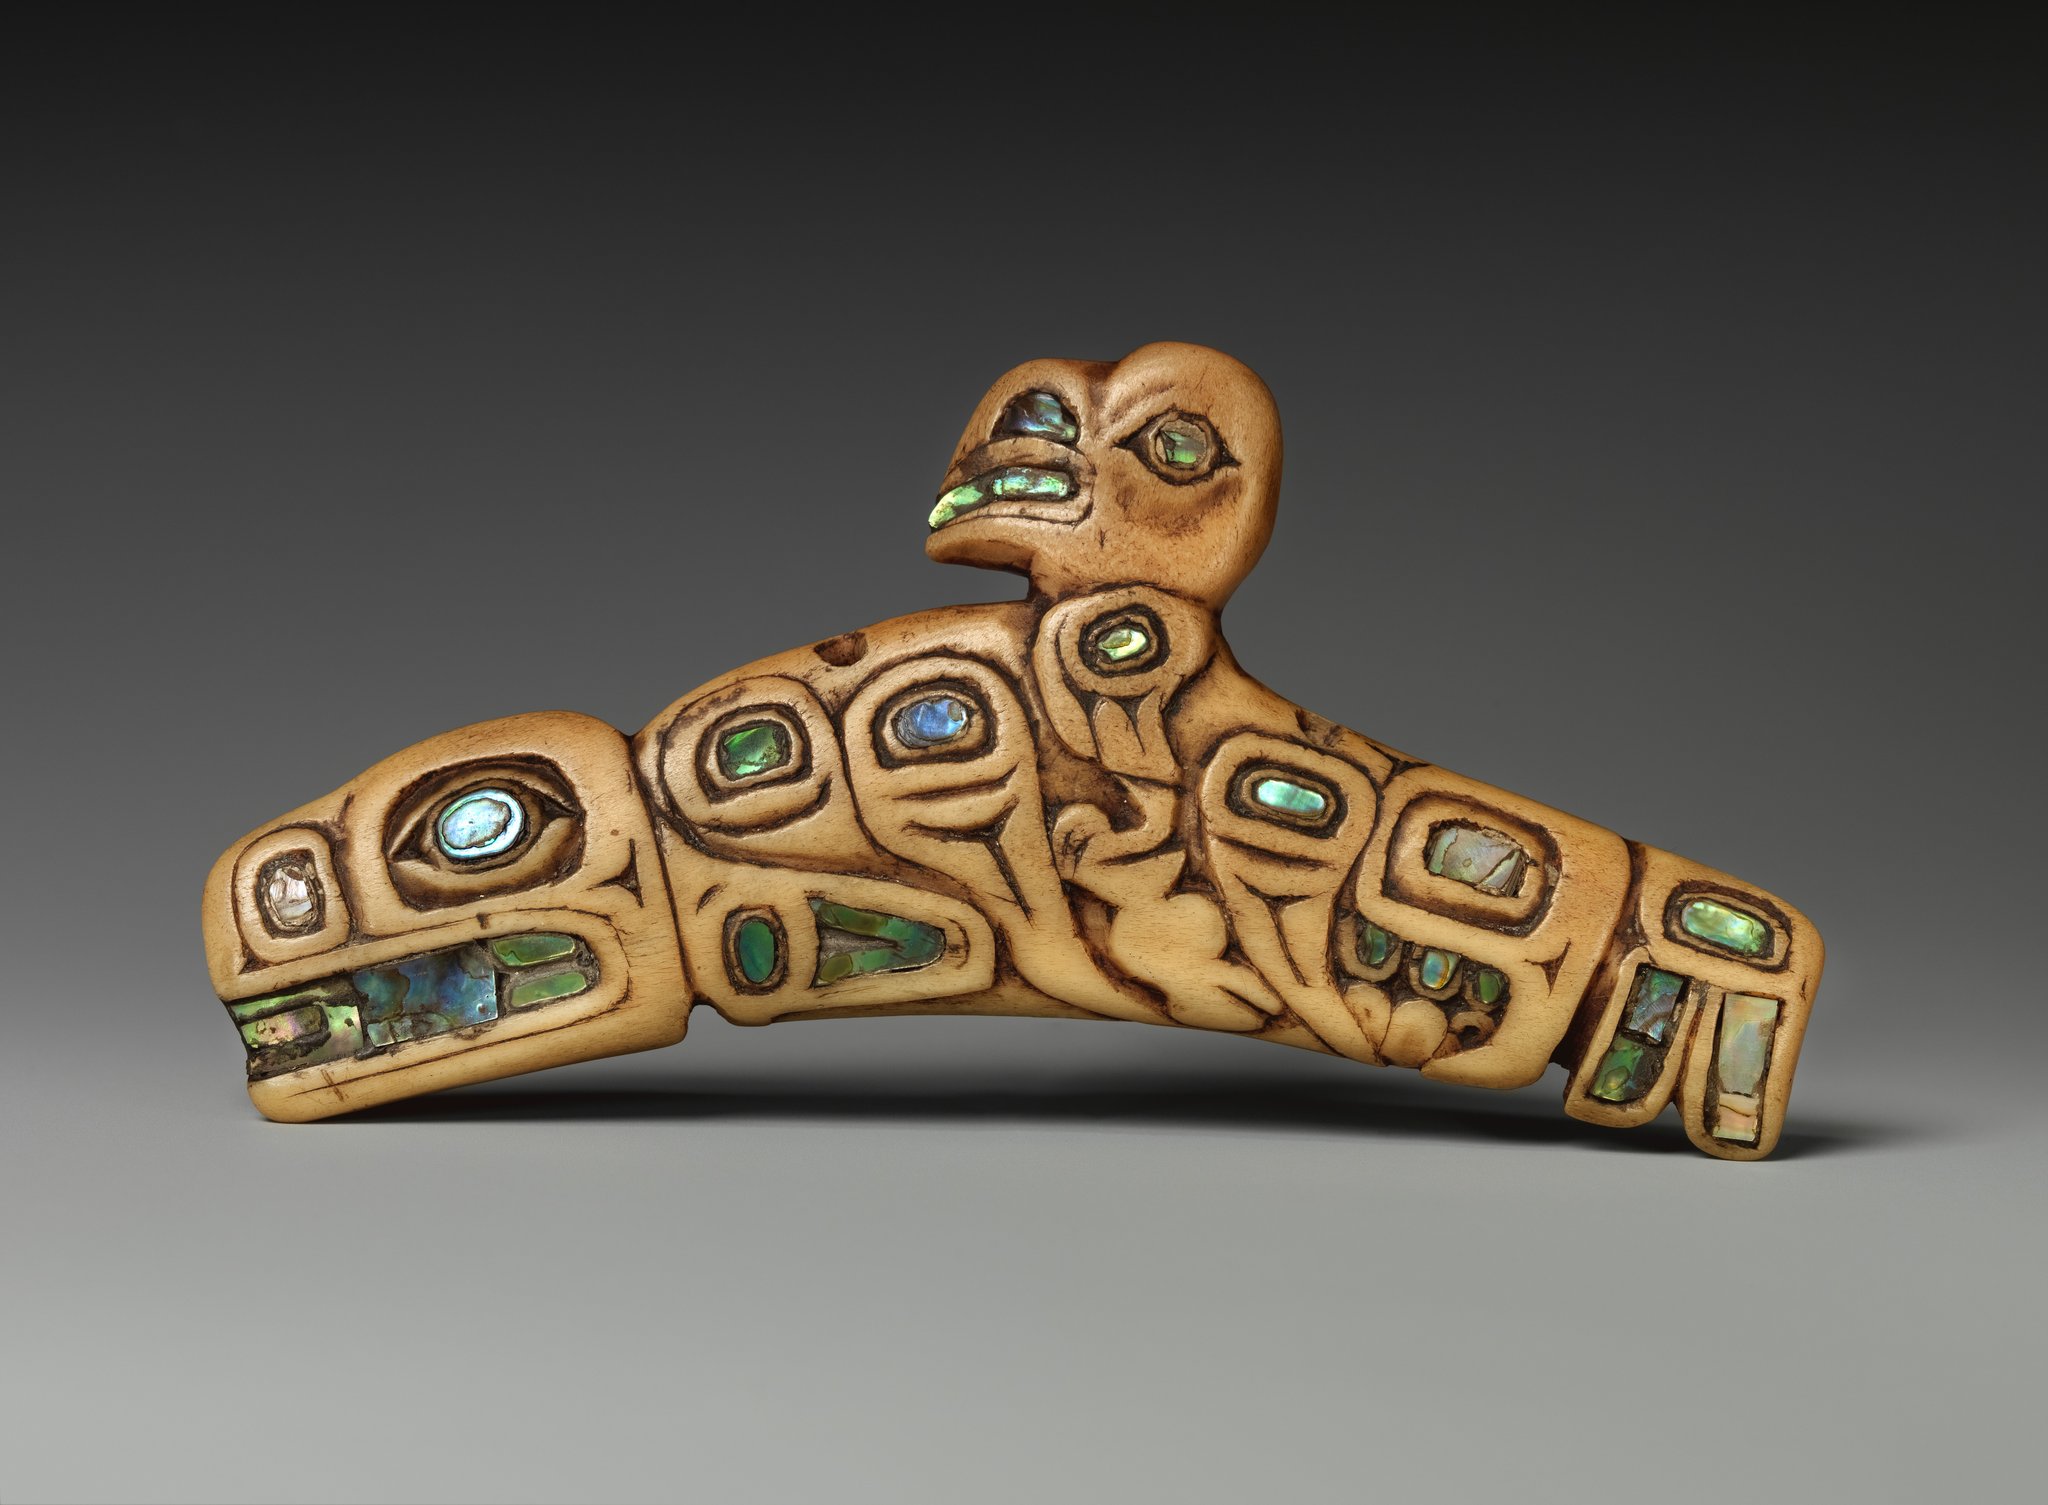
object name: necklace, bead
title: Amulet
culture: tlingit or native american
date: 1840-1870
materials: antler, shell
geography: united states